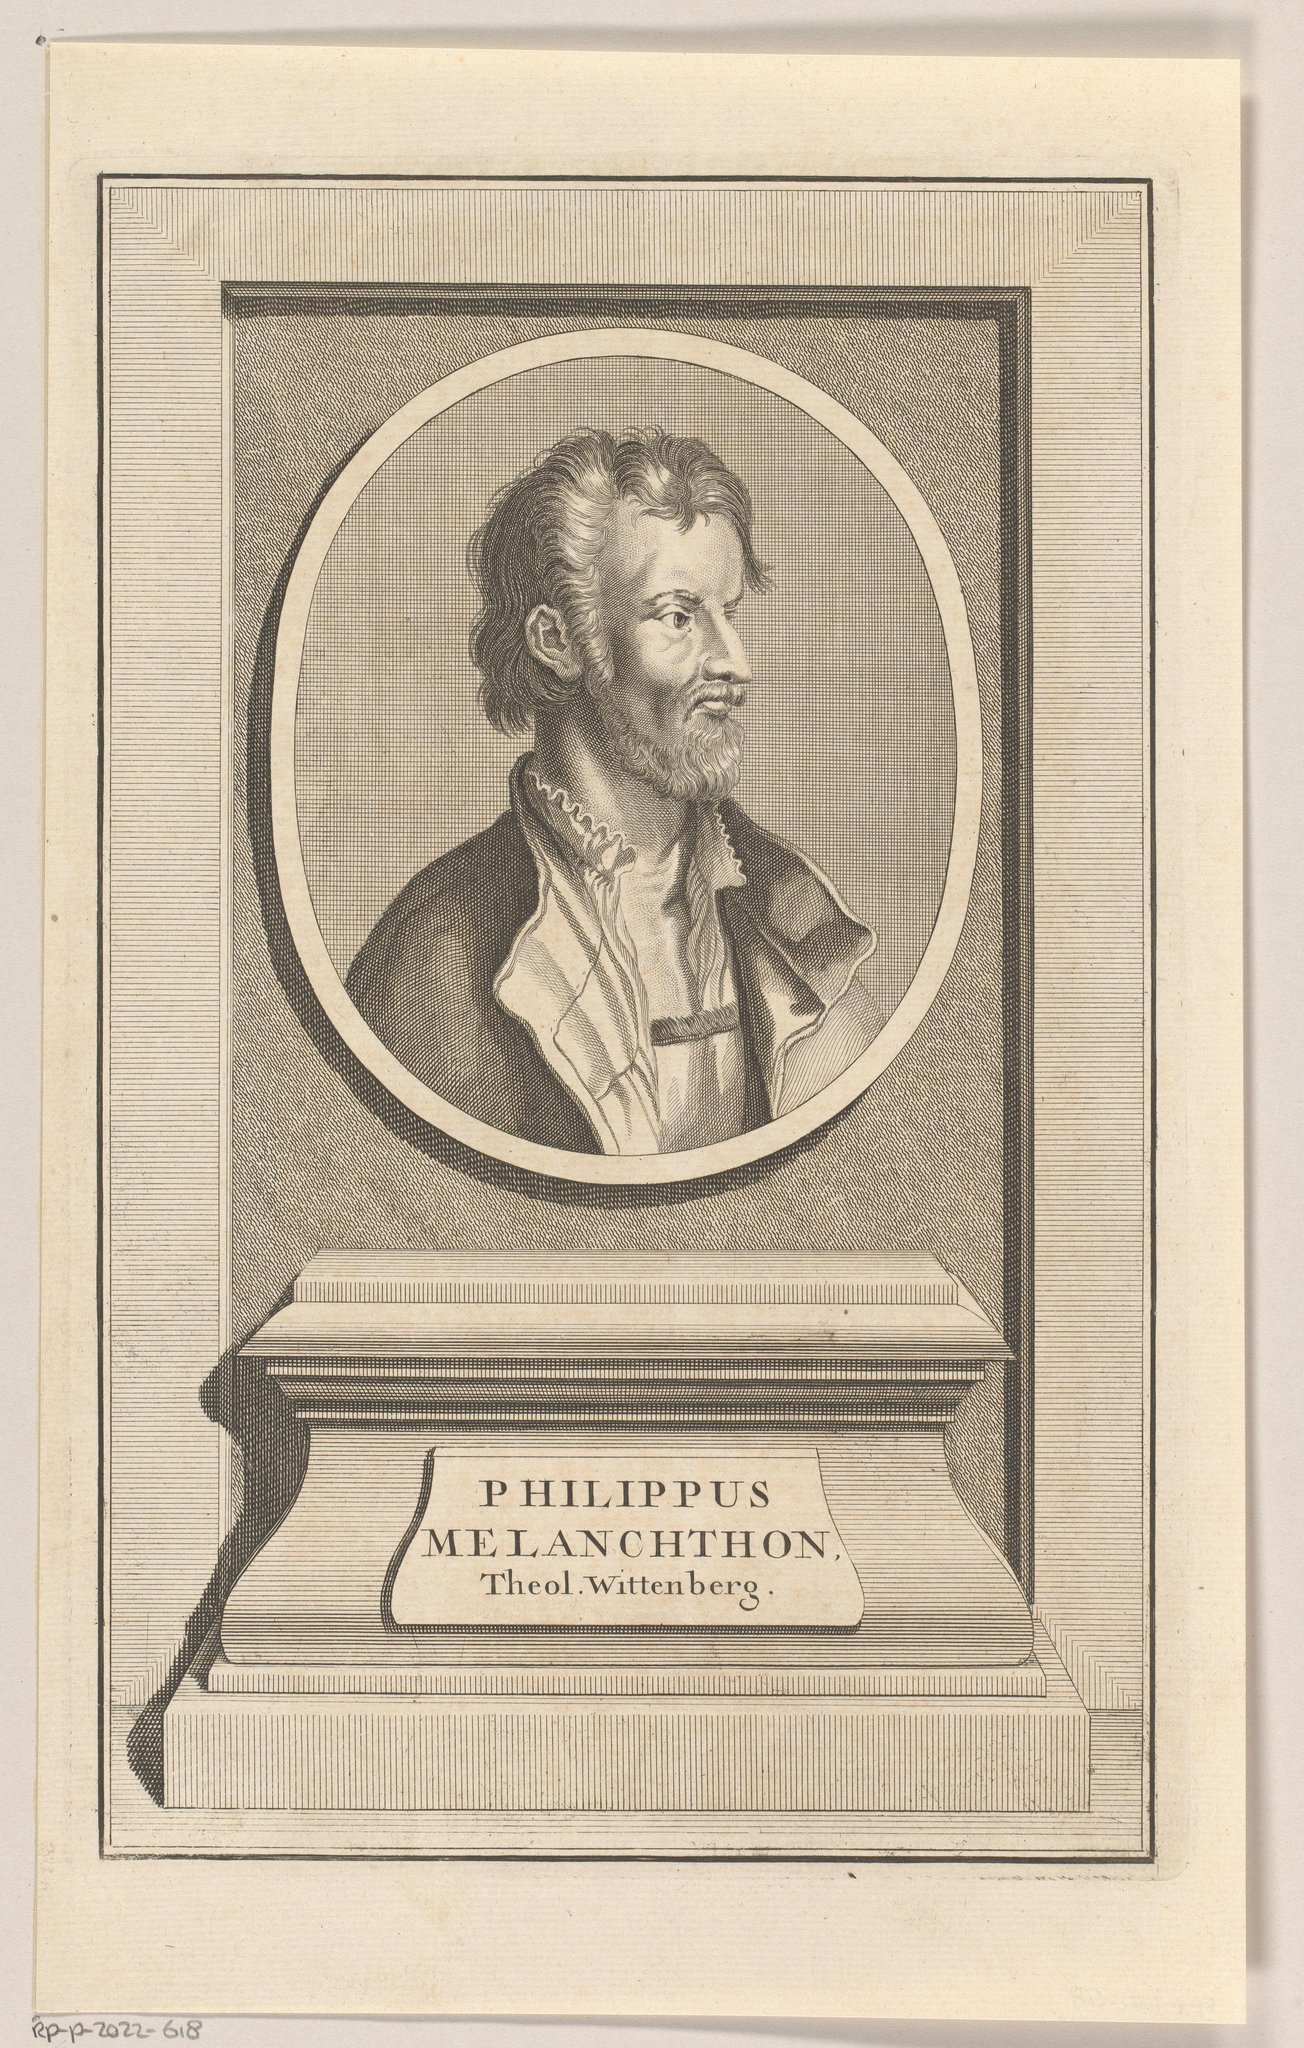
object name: print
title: Portret van Philipp Melanchthon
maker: Anonymous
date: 1600-1800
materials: paper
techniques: engraving, etching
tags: theologian, historical persons